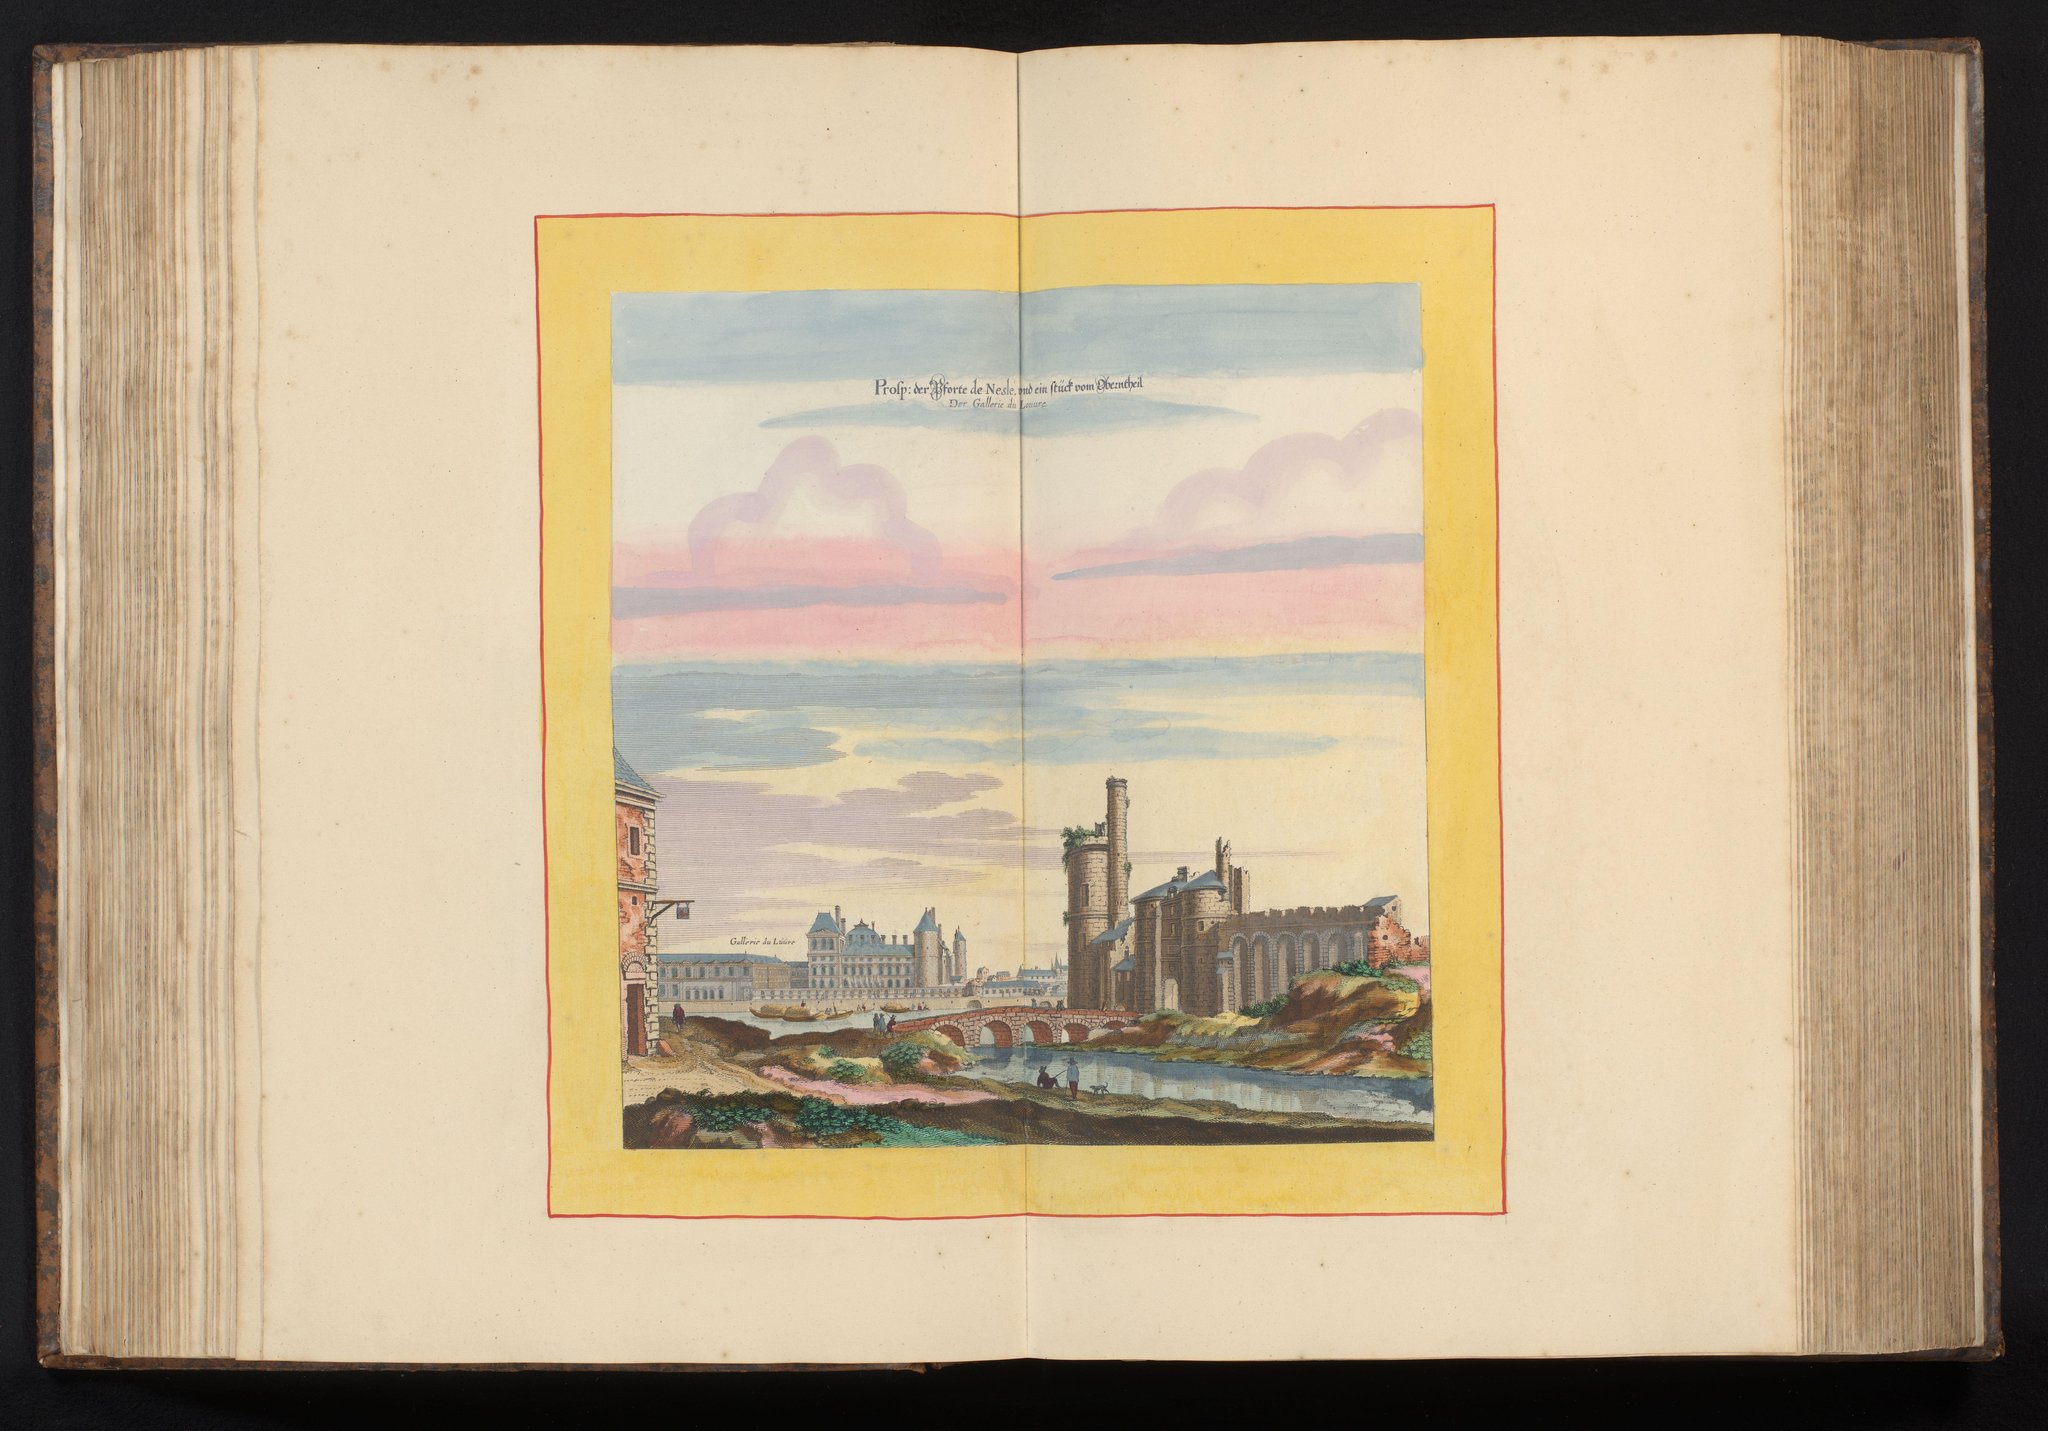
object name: album leaf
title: Prosp. du Pforte de Nesle und ein stück vom Oberntheil Der Gallerie du Louvre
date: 1655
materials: paper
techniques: engraving, etching, hand coloring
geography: the hague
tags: city-gate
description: Prent origineel vervaardigd als boekillustratie voor: Zeiller, Martin. Topographia Galliae, oder Beschreibung und Contrafaitung der vornehmbsten und bekantisten Oerter in dem mächtigen und grossen Königreich Frankreich, 13 delen. Frankfurt am Main: Caspar Merian, 1655-1661. De prent werd voor het eerst gepubliceerd in deel 1: Topographia Galliae, 1655. De prent is langs de bovenrand van de voorstelling afgescheurd. Het bovenste gedeelte is hoger opgeplakt, zodat de lucht hoger is geworden en het formaat van de voorstelling past bij de andere groot formaatvoorstellingen in het album. De voorstelling is aan de bovenzijde aangevuld met een geschilderde lucht.